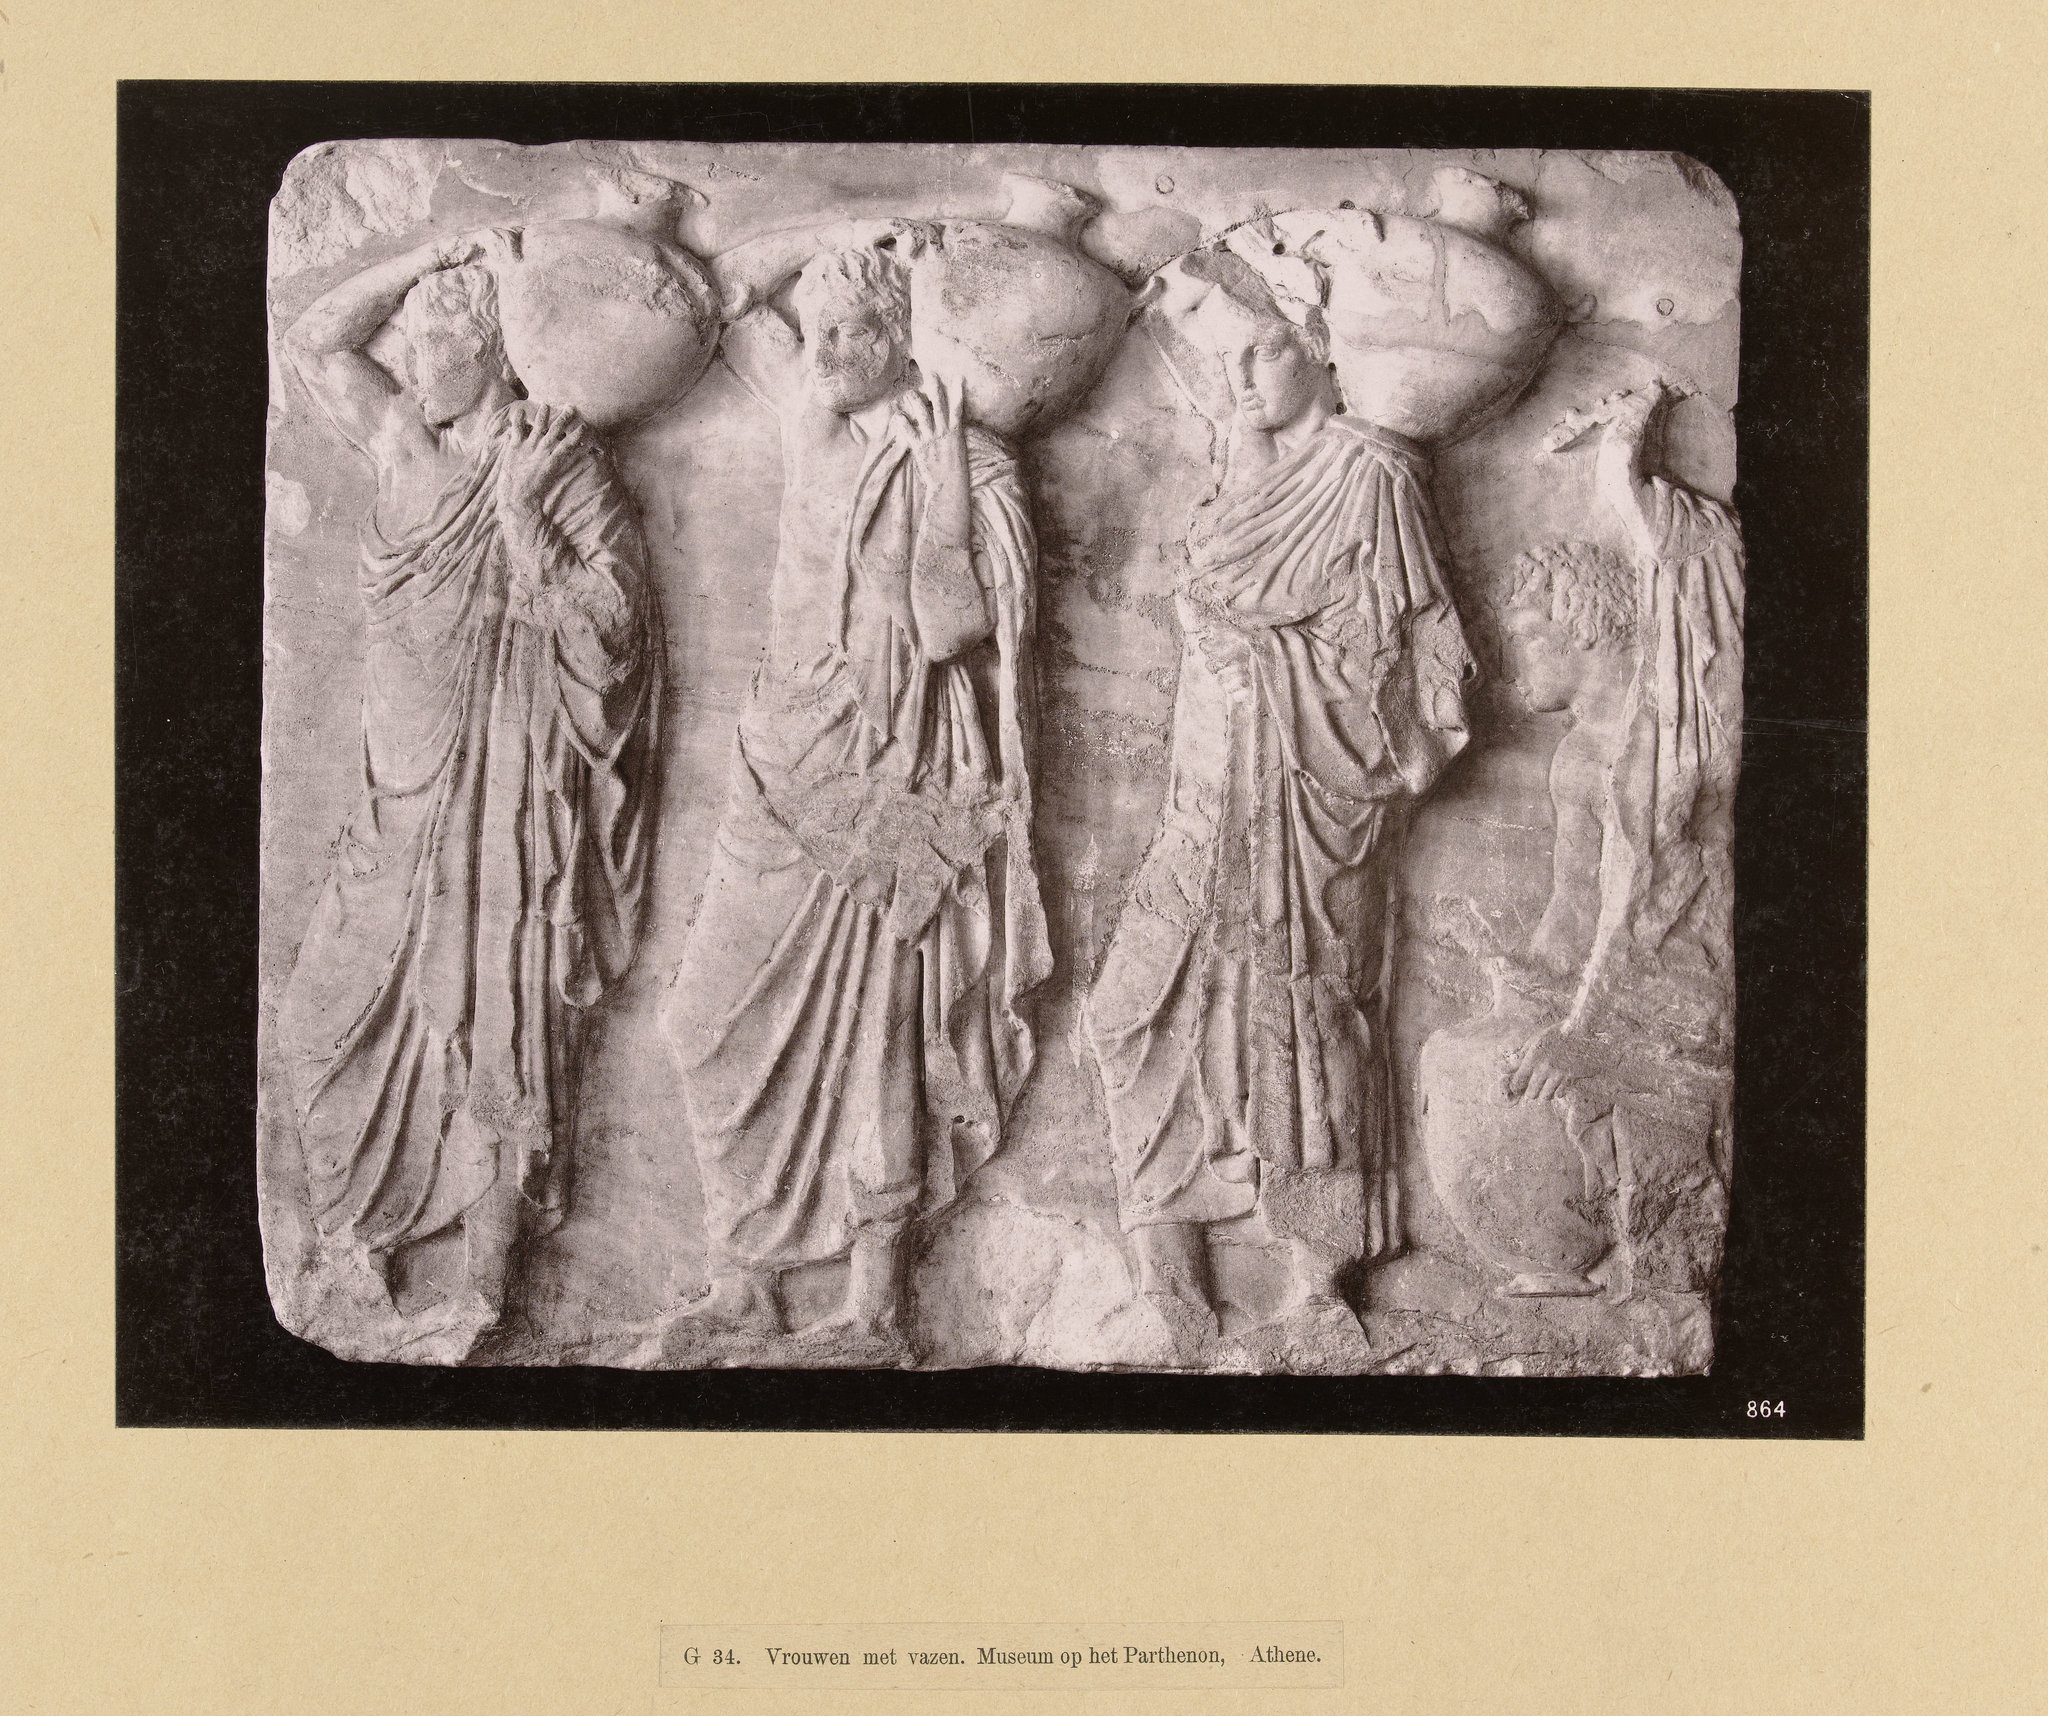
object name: photomechanical print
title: Reliëf van vrouwen met vazen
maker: Anonymous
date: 1890-1893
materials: cardboard, paper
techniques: photograph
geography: athens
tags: piece of sculpture, reproduction of a piece of sculpture, carrying something on the head or on the shoulders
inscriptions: inscription: ‘G 34. Vrouwen met vazen. Museum op het Parthenon, Athene.’, number: ‘864’, check stamp: ‘Bristol/ L.M.’, stamp: ‘Gemeentelijke bibliotheek/ Rotterdam’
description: Onderdeel van een groep door fotograaf Richard Polak op reis verzamelde foto’s. Deze fotomechanische afdruk is samen met andere op zijn reizen verzamelde foto's tentoongesteld bij de Rotterdamsche Kunstkring (1895), Arti en Amicitiae te Amsterdam (1897-1898?) en Societeit 't Collegie te Kampen (datum vooralsnog onbekend).